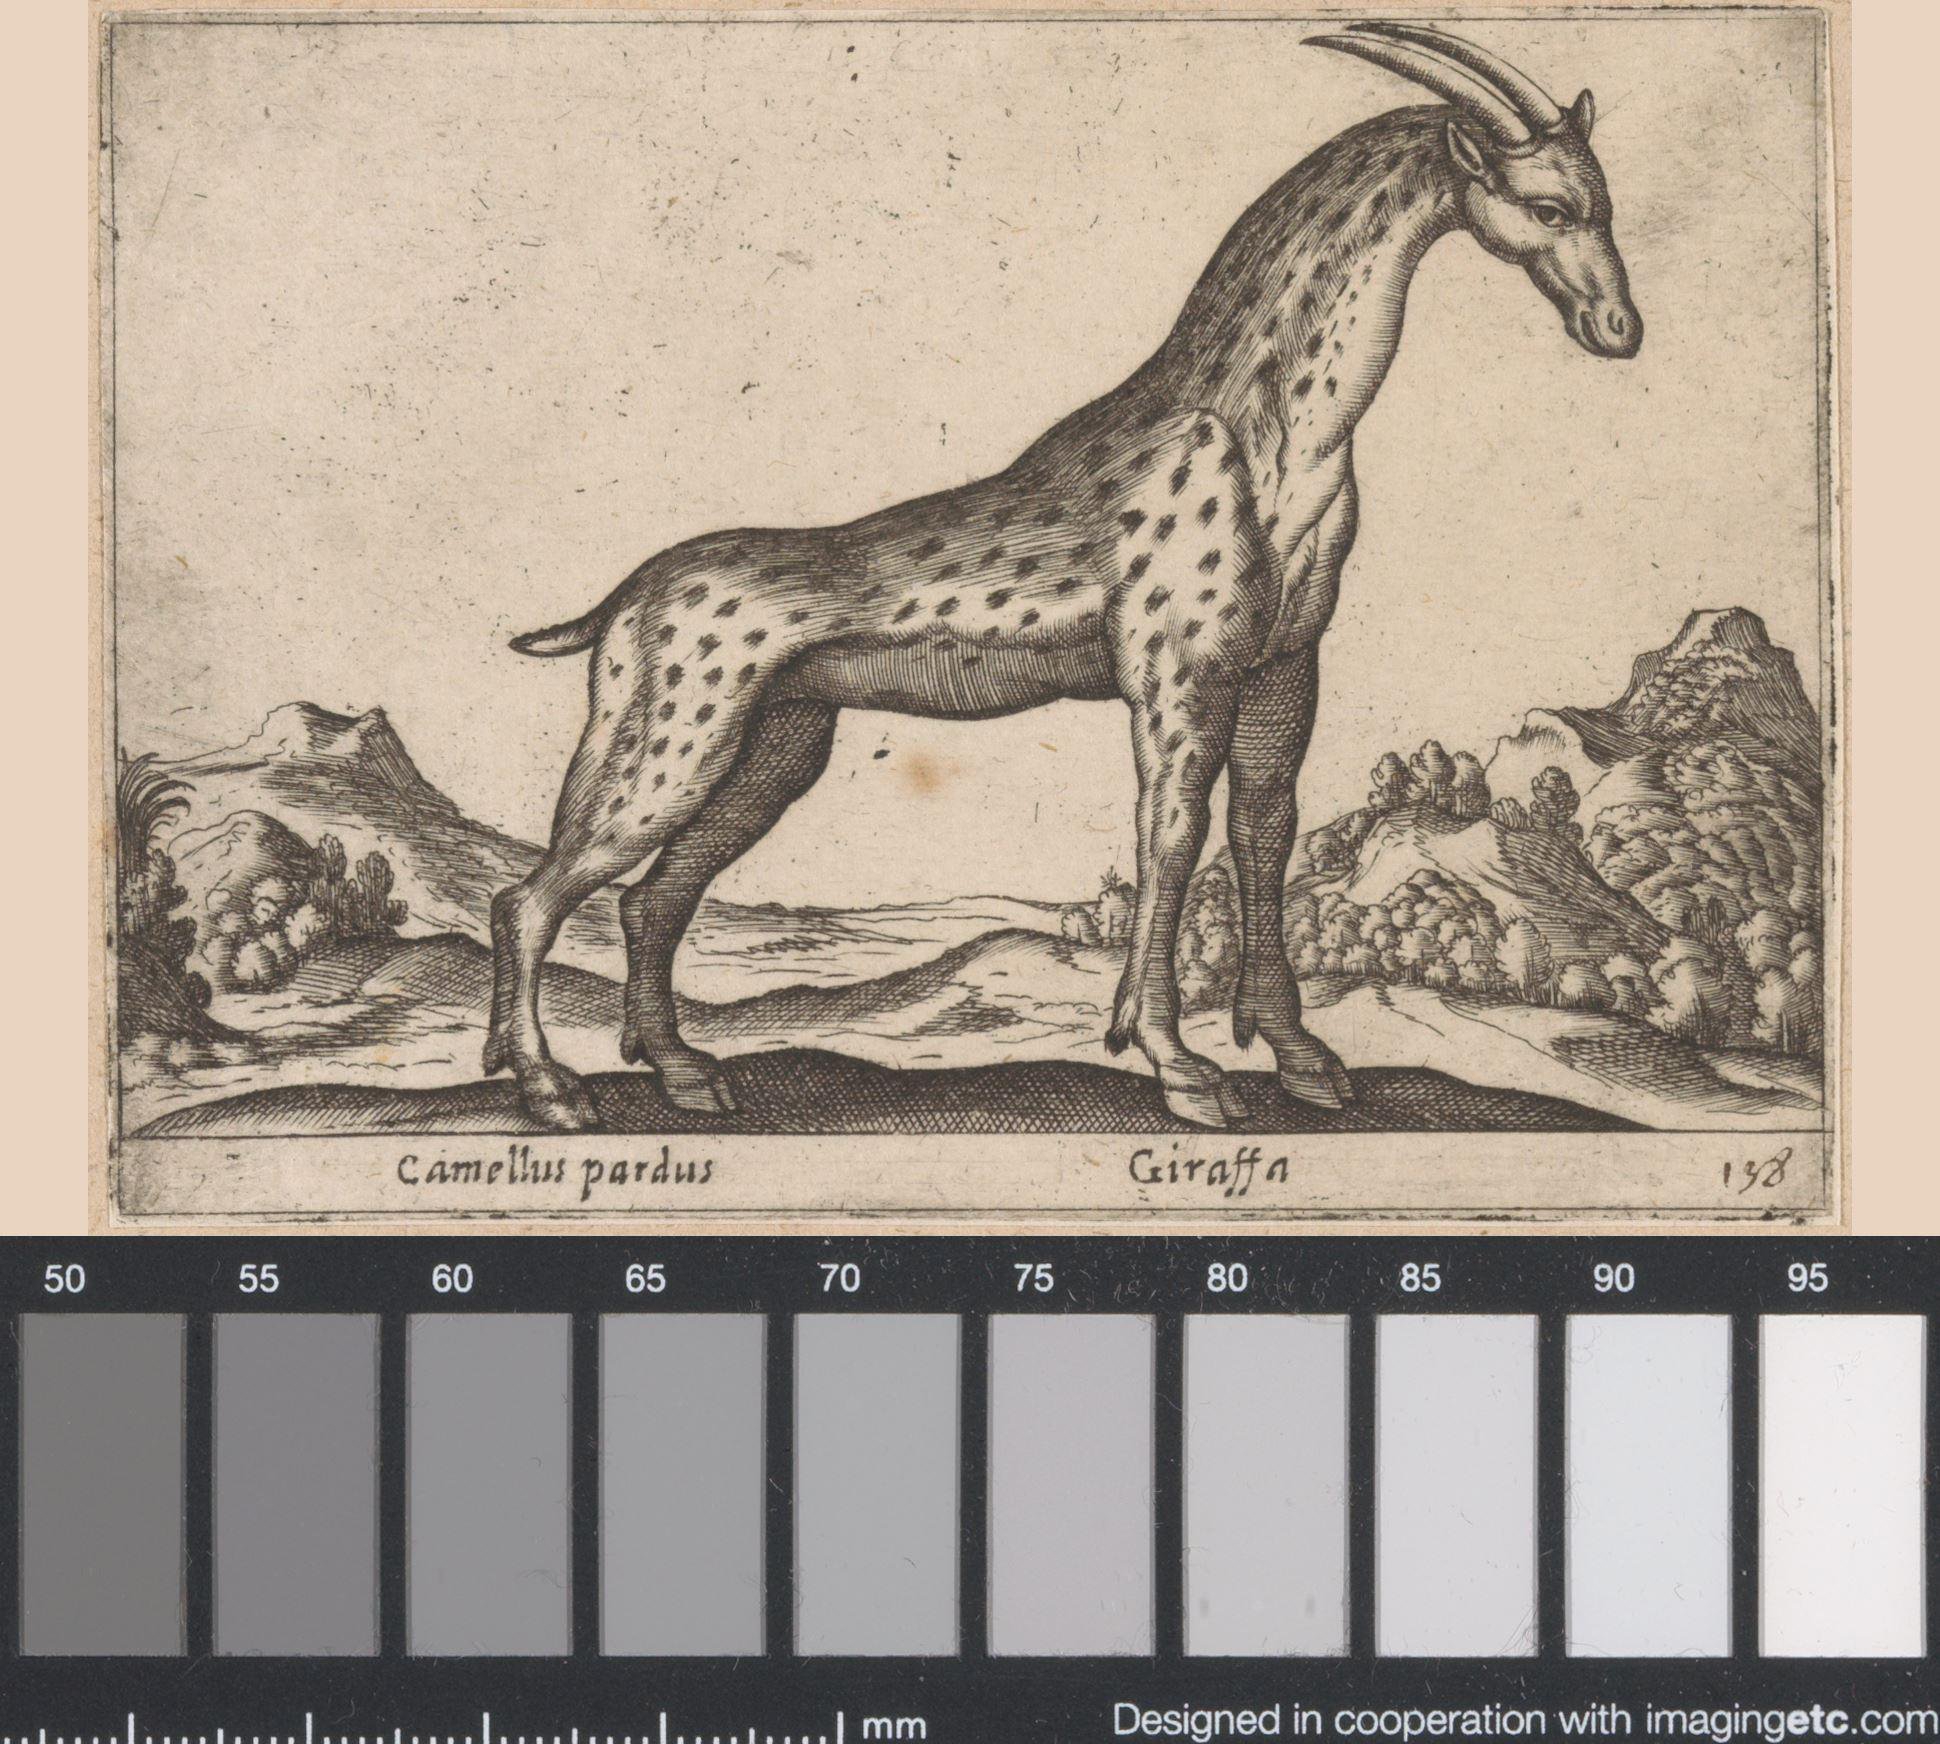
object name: print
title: Dieren en fabelwezens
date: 1565-1630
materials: paper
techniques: etching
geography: italy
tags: hoofed animals: giraffe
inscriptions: collector's mark: Lugt 11, number: ‘138’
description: Deze prent maakt deel uit van een reeks prenten van dieren door Antonio Tempesta. Bekend is dat een tweede staat (met nummering) van deze serie is uitgegeven door Giovanni Giacomo de' Rossi in 1650. Onbekend is wie de eerste staat heeft uitgegeven en wanneer.